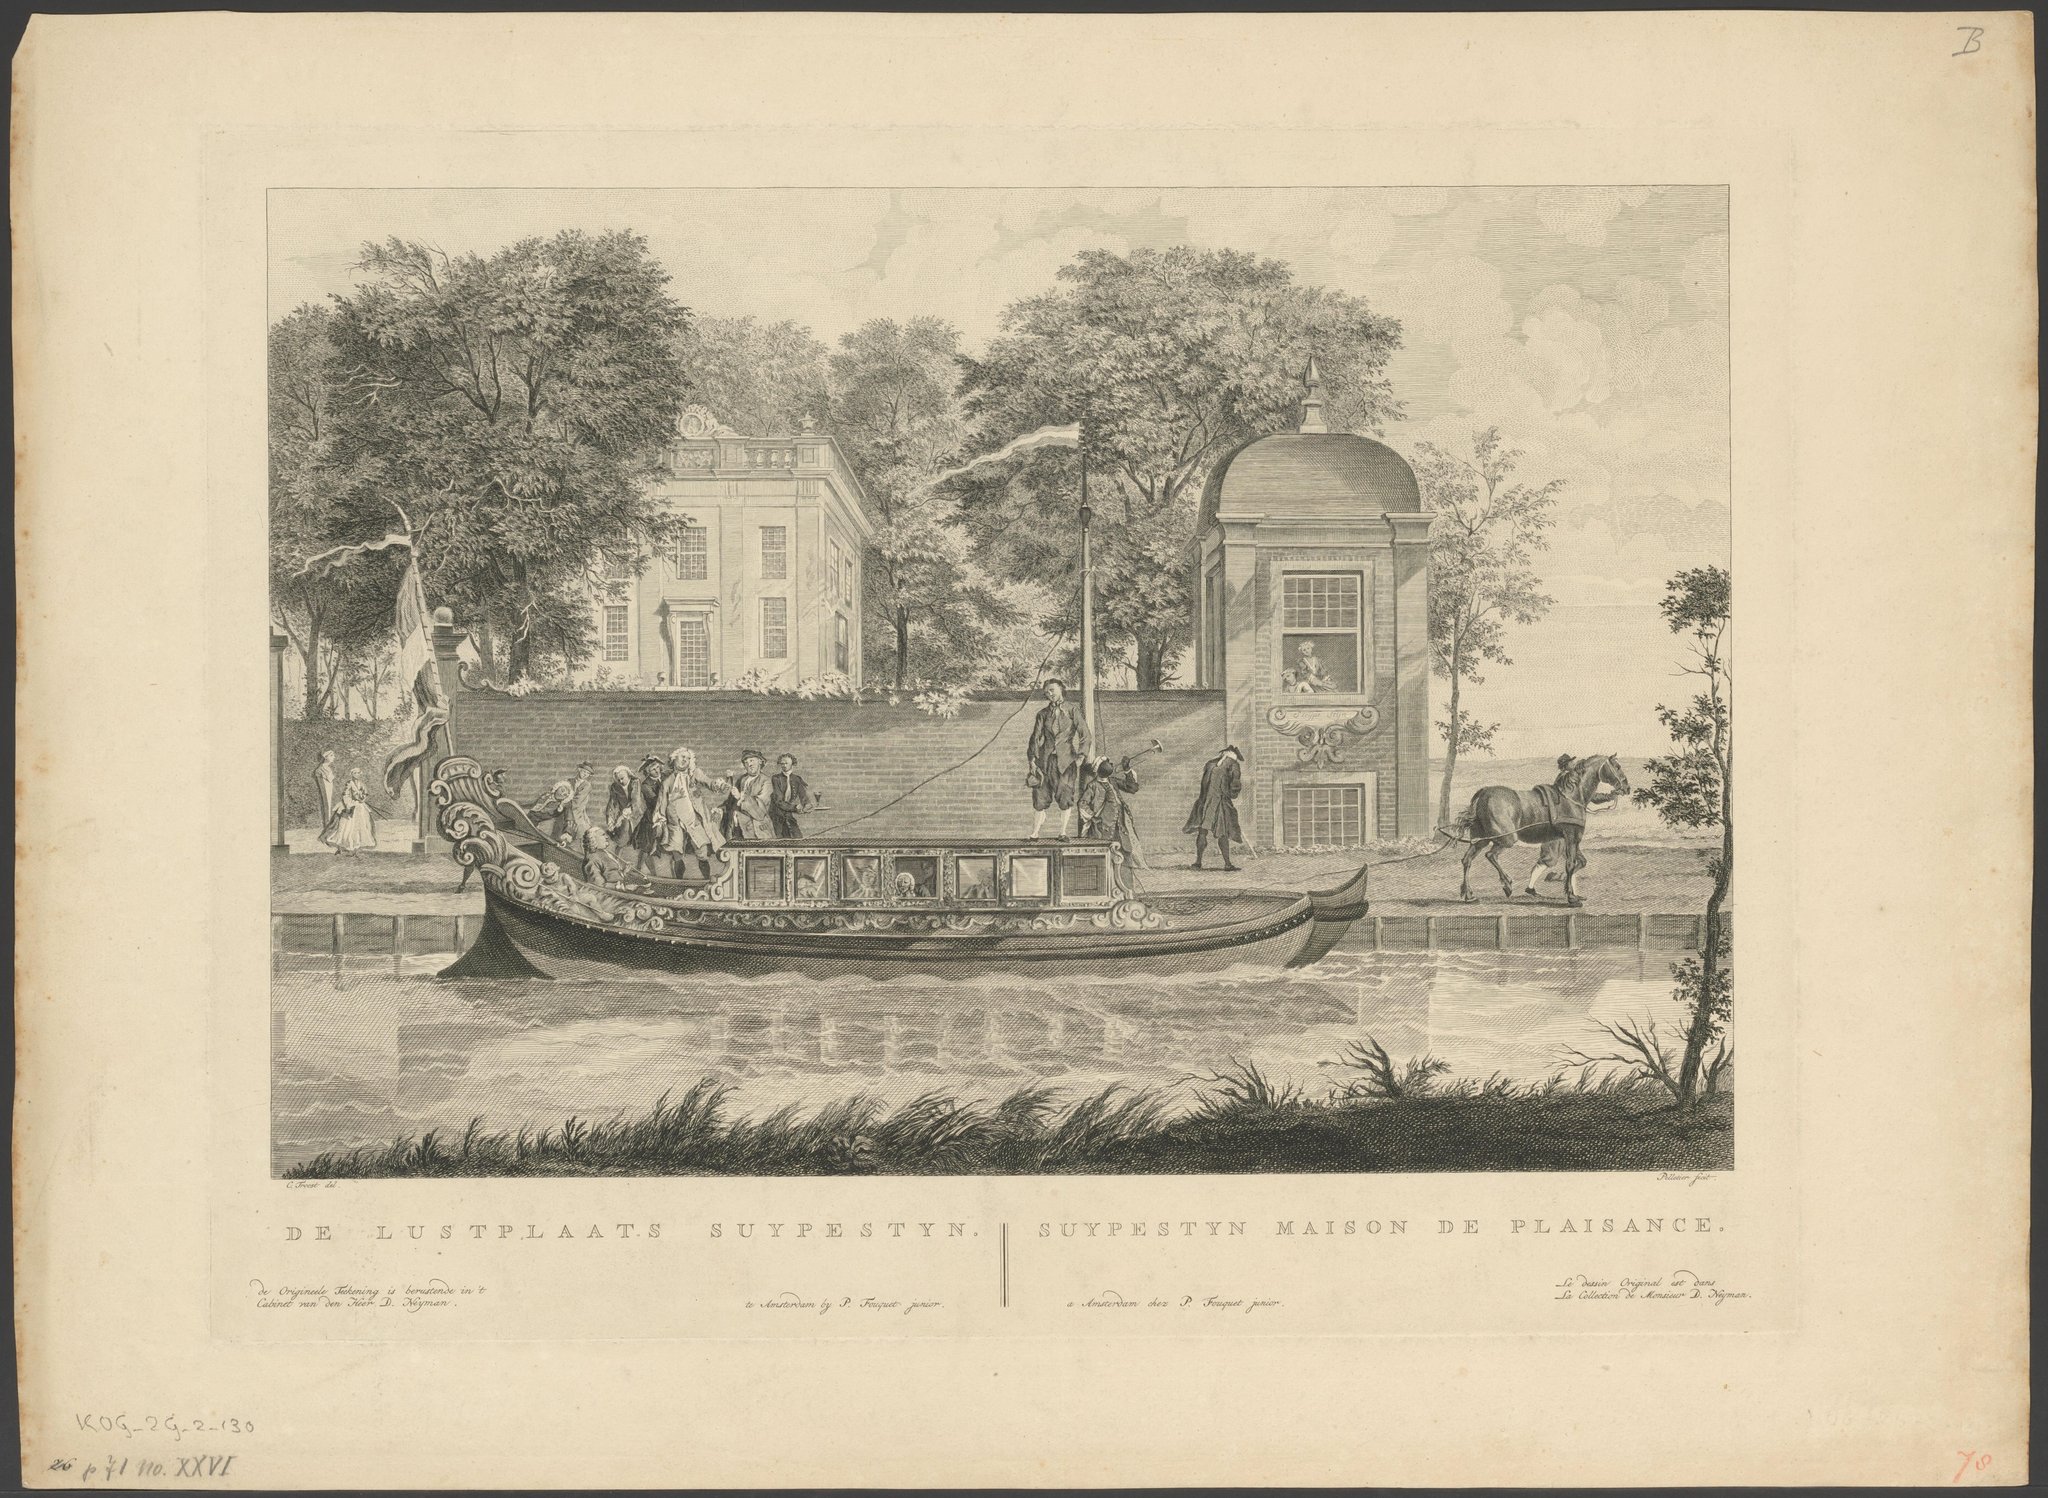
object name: print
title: Buitenplaats met dronken gezelschap dat aan boord gaat van een trekschuit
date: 1754-1764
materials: paper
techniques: engraving, etching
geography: amsterdam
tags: (descendants of) african emigrants, person migrating from africa (the netherlands), rural housing, e.g. country-house, villa, cottage, horn, trumpet, cornet, trombone, tuba - cc - out of doors, tow-boat, towing-barge, drunkenness, urination, house personnel, servants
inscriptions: collector's mark: Lugt 2488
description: Buitenplaats met dronken gezelschap dat aan boord gaat van een trekschuit. Een man plast nog even tegen een muur. Aan boord blaast een zwarte jongen op een trompet.